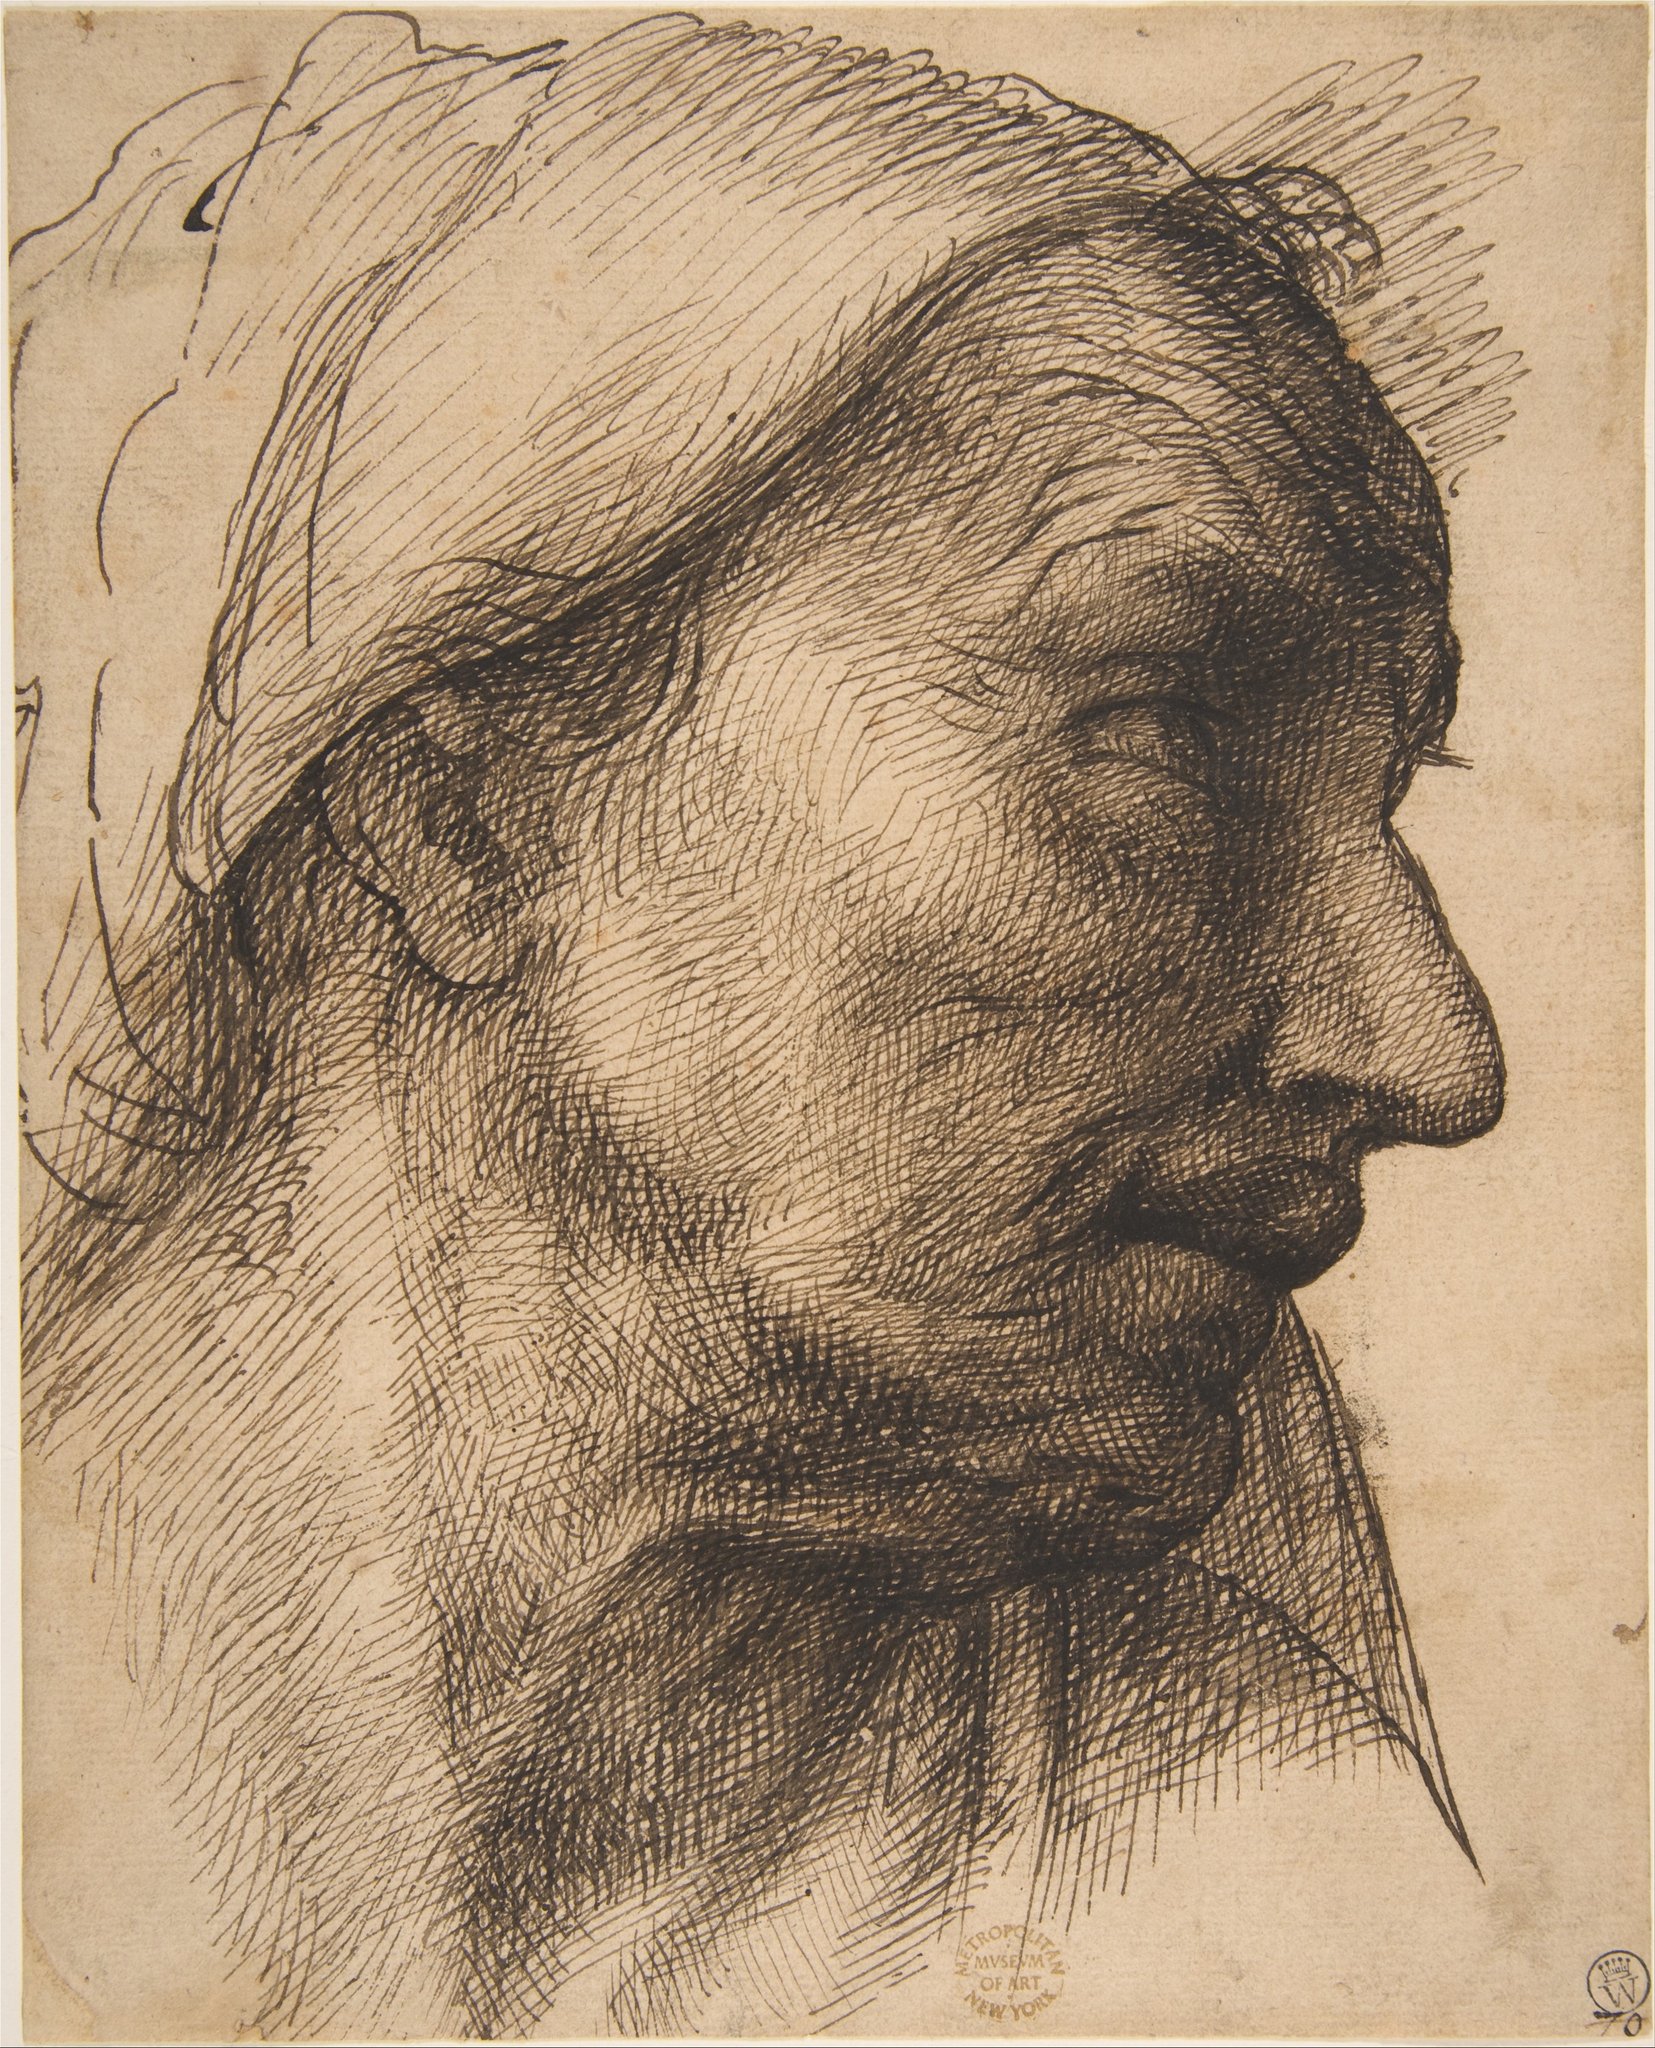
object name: drawing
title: Head of an Old Woman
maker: sebastiano del piombo (sebastiano luciani)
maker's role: artist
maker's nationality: italian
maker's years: 1485-1547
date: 1485-1547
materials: ink, paper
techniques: pen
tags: heads,profiles,women